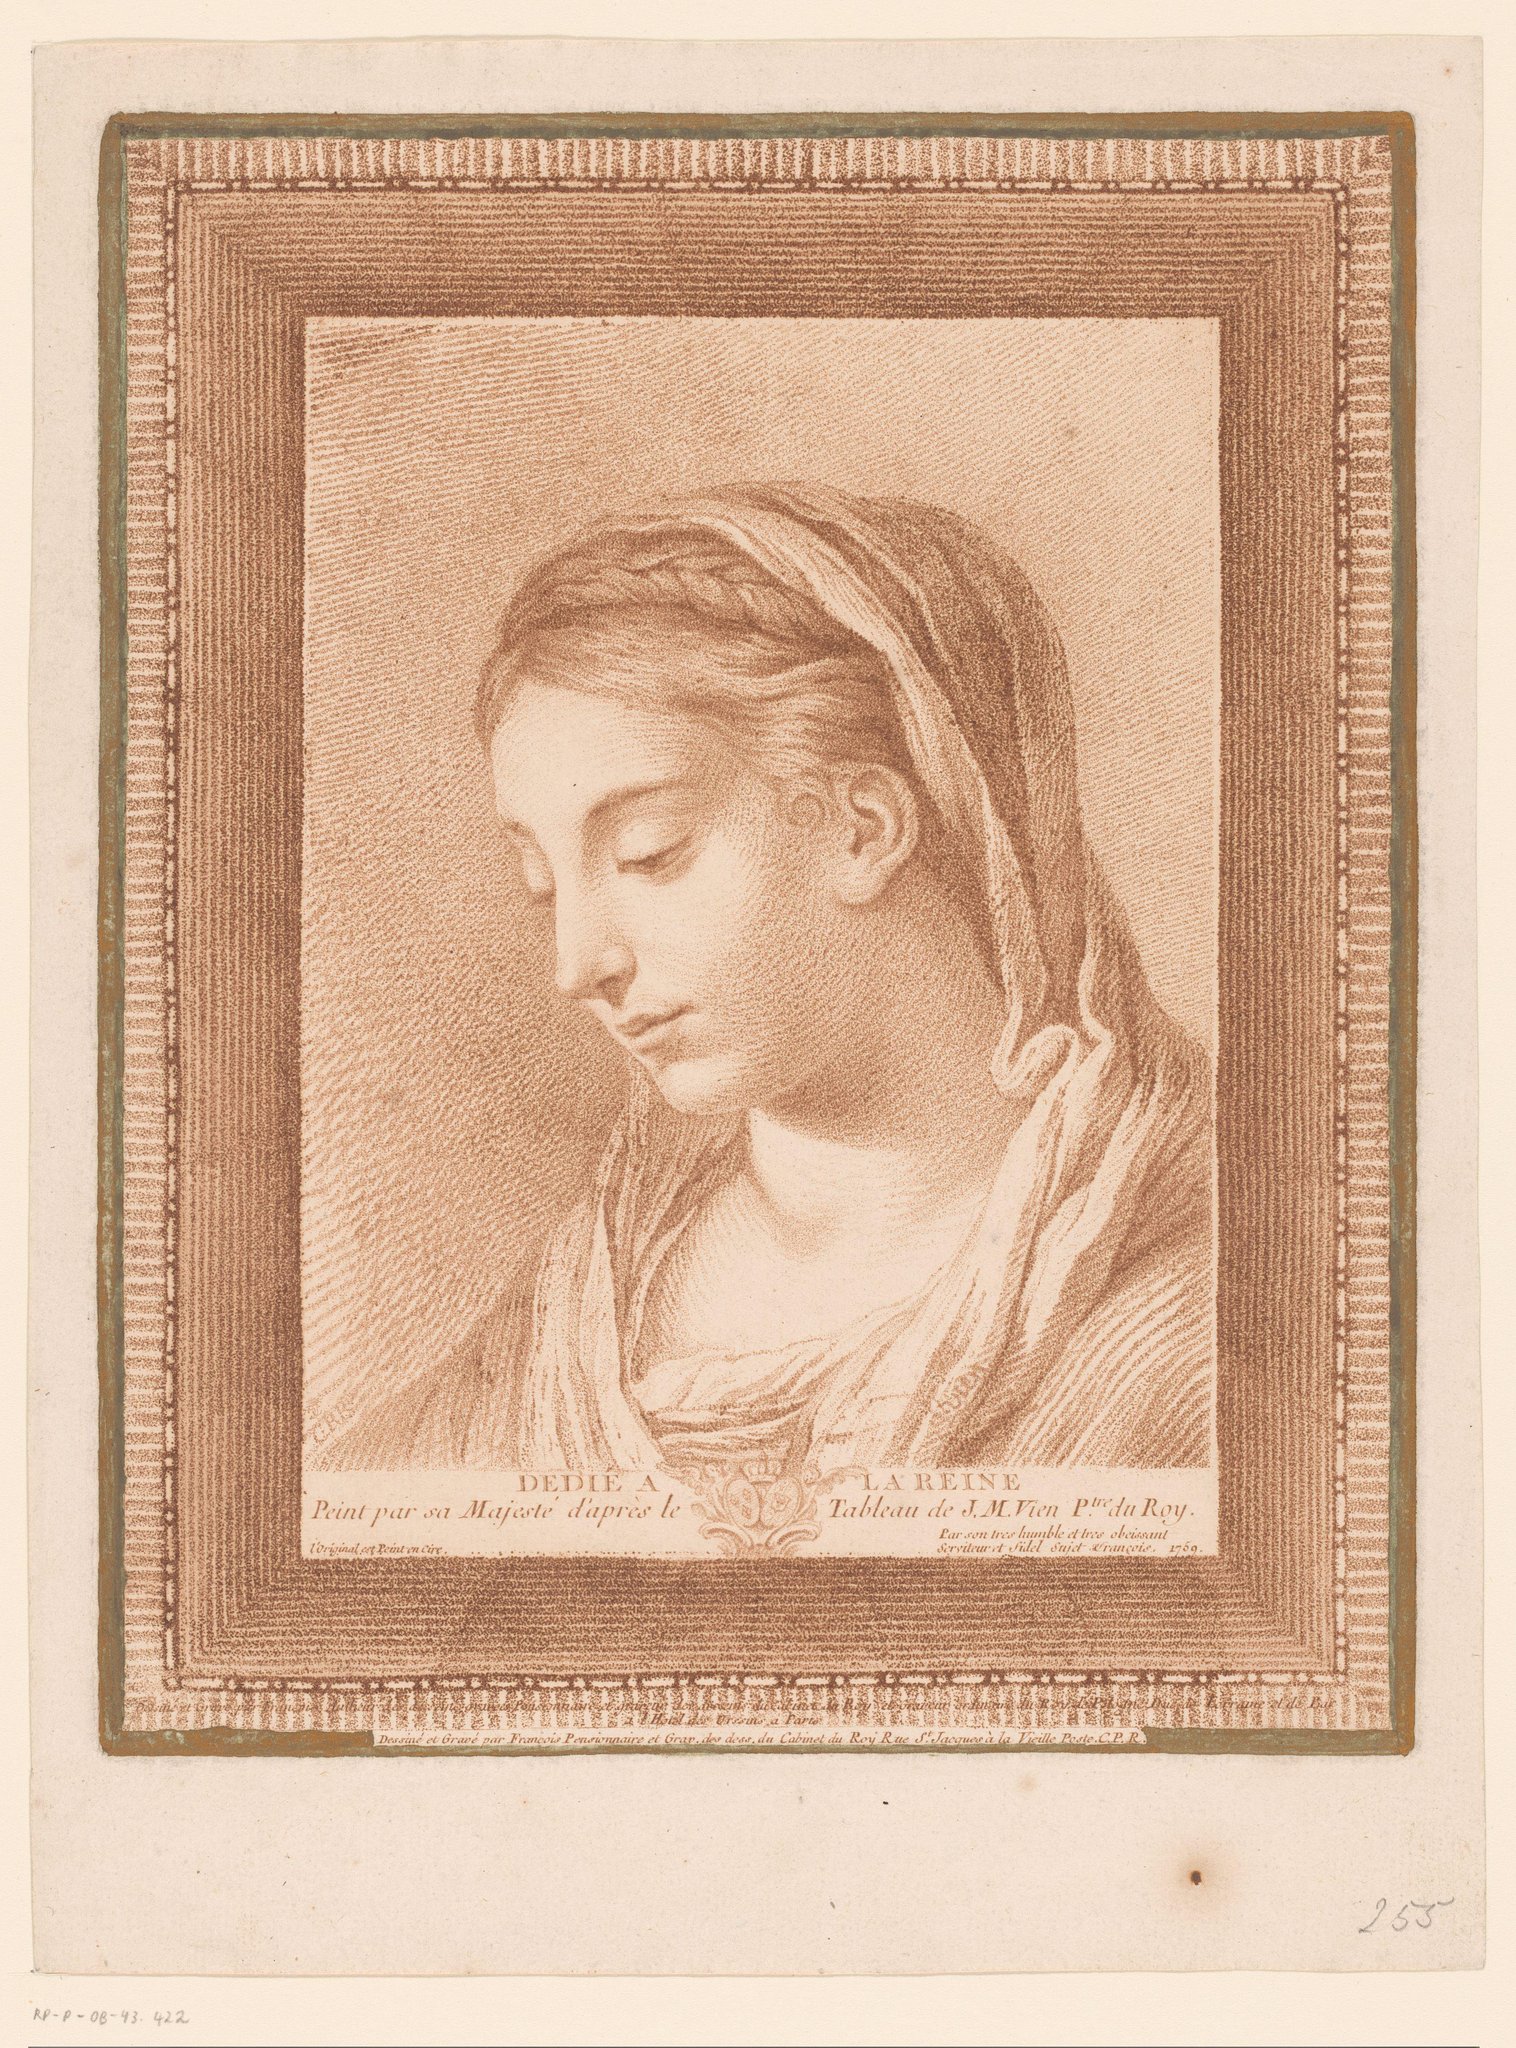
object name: print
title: Hoofd van Maria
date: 1759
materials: paint, paper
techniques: brush, printmaking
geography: france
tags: mary (without the christ-child)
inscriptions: collector's mark: Lugt 2228